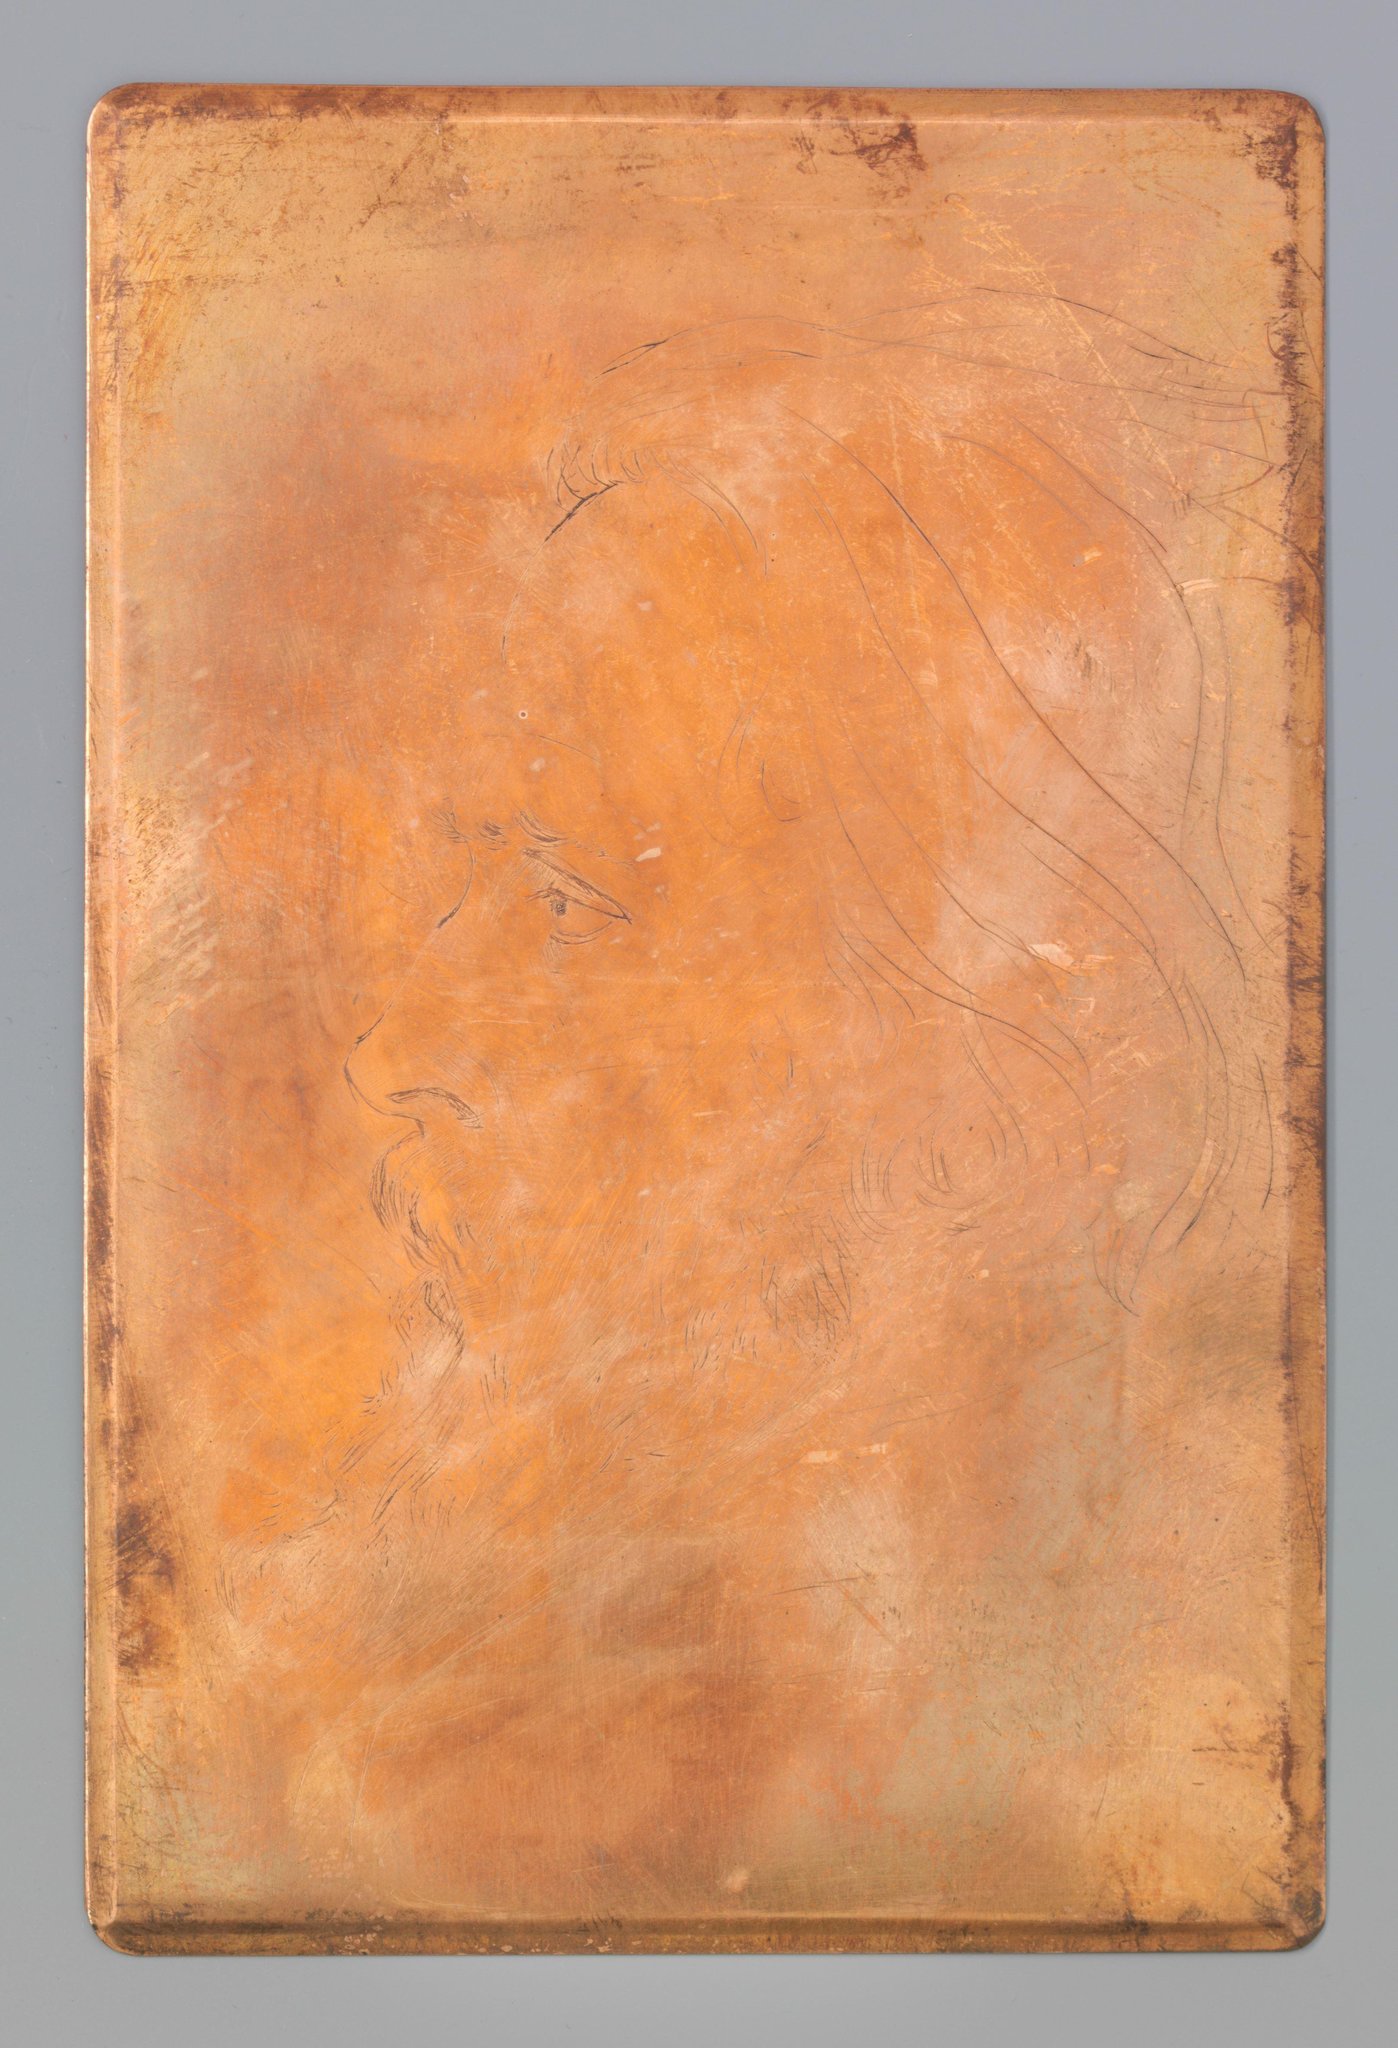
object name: copper plate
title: Portret van William Degouve de Nunques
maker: jan toorop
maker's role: draughtsman, painter, print maker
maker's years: 1858-1928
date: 1904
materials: copper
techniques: drypoint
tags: print maker, william degouve de nuncques